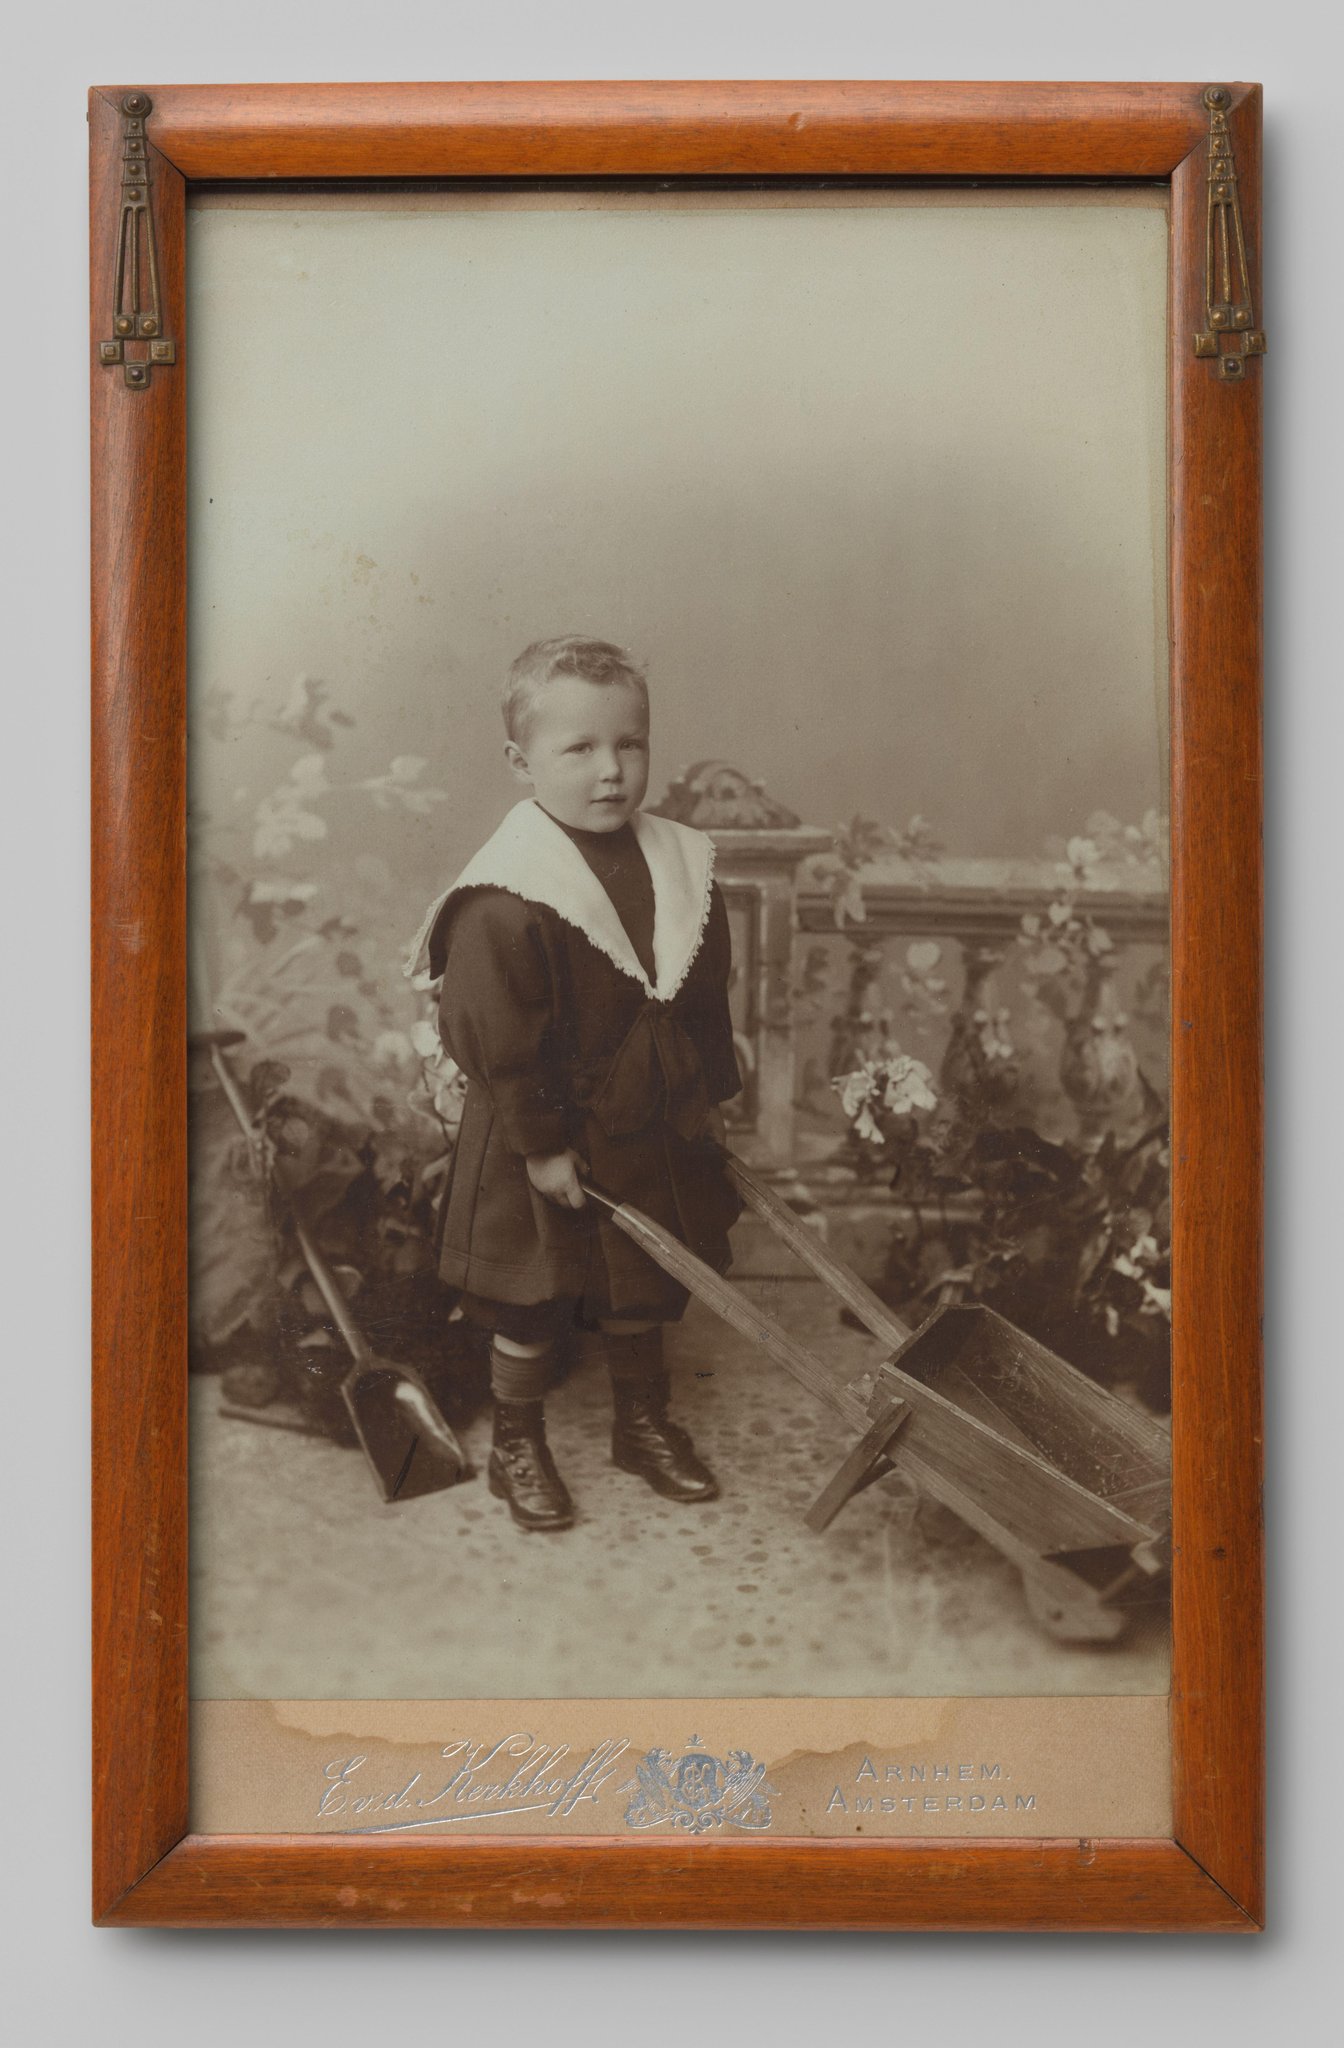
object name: frame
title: Portret van een onbekende jongen met kruiwagen en schep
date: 1902-1908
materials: cardboard, glass, metal, paper, wood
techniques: gelatin silver print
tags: toddler (male), anonymous historical person portrayed, wheelbarrow